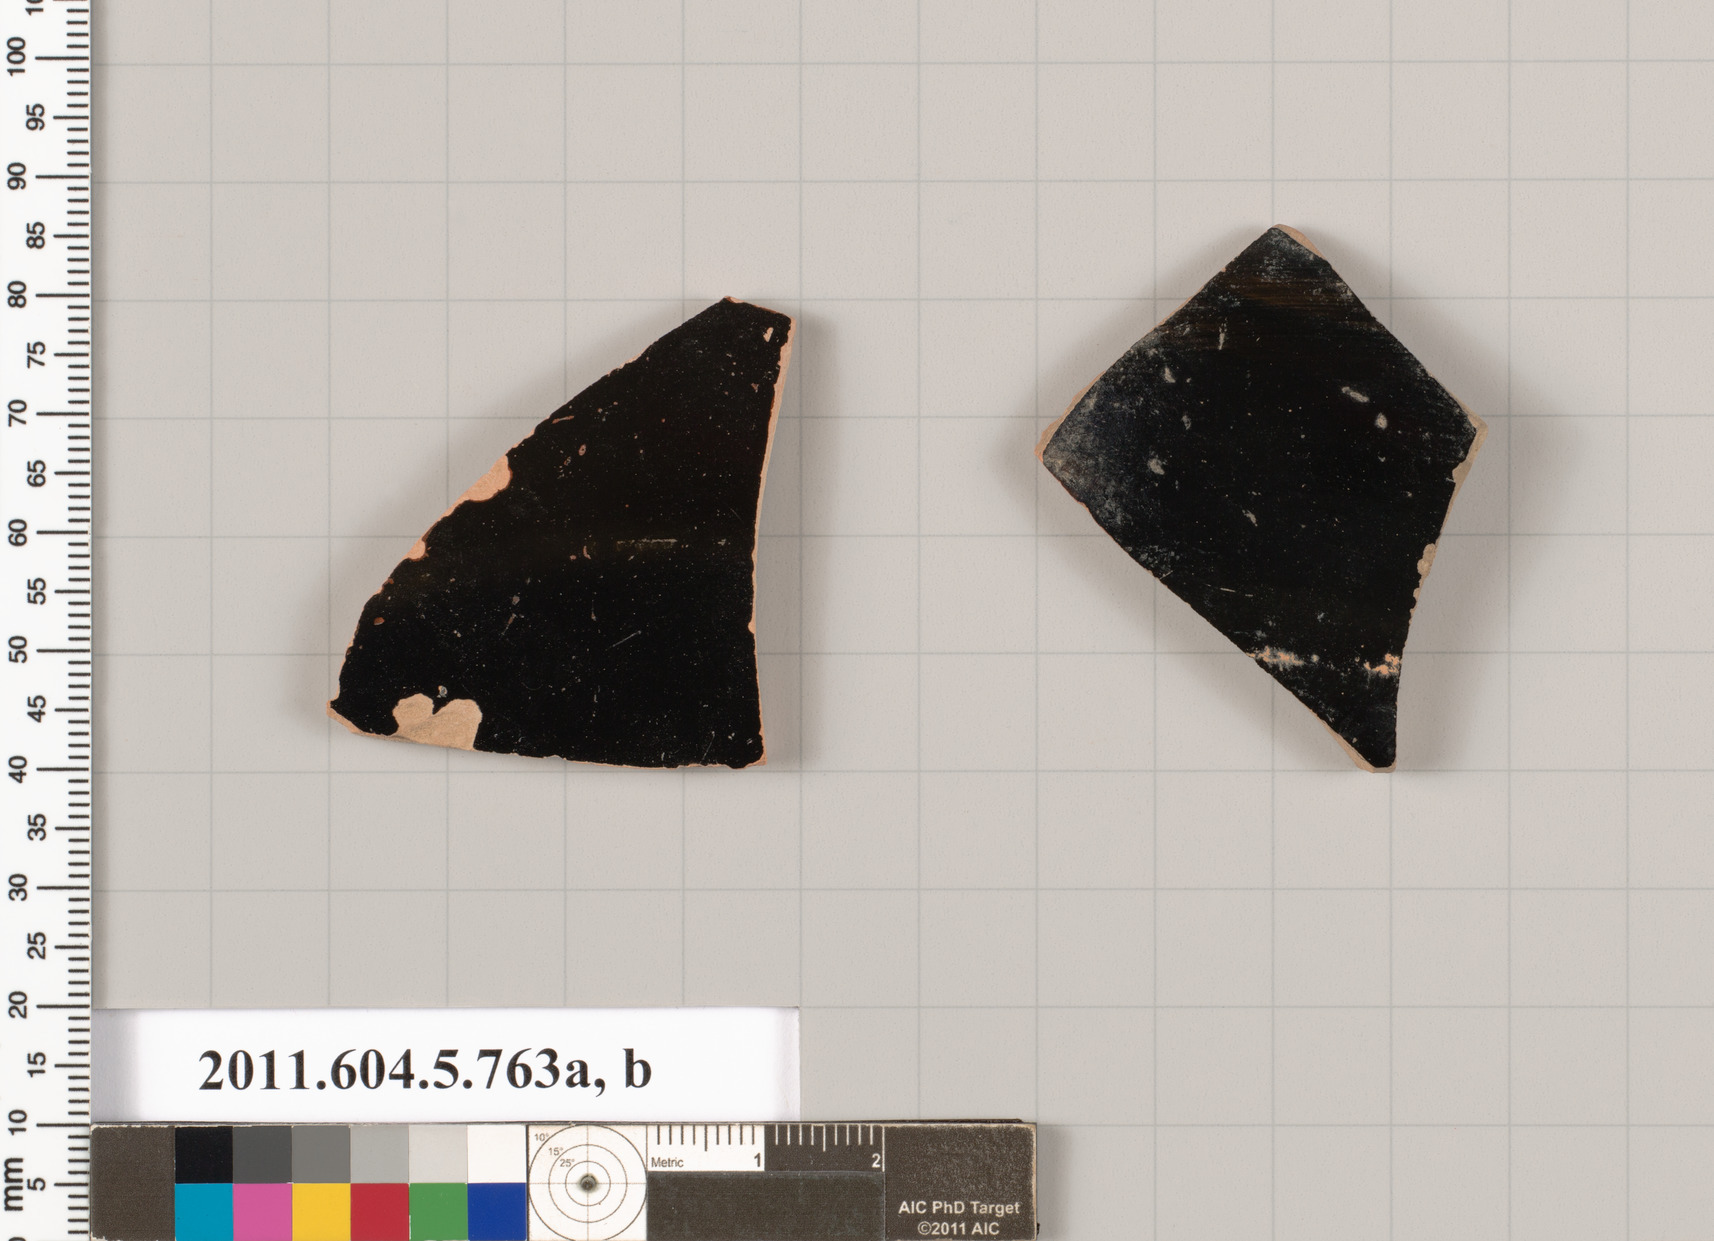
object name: kylix fragment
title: Terracotta fragments of kylikes (drinking cups)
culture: greek, attic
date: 600-401 BCE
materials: terracotta